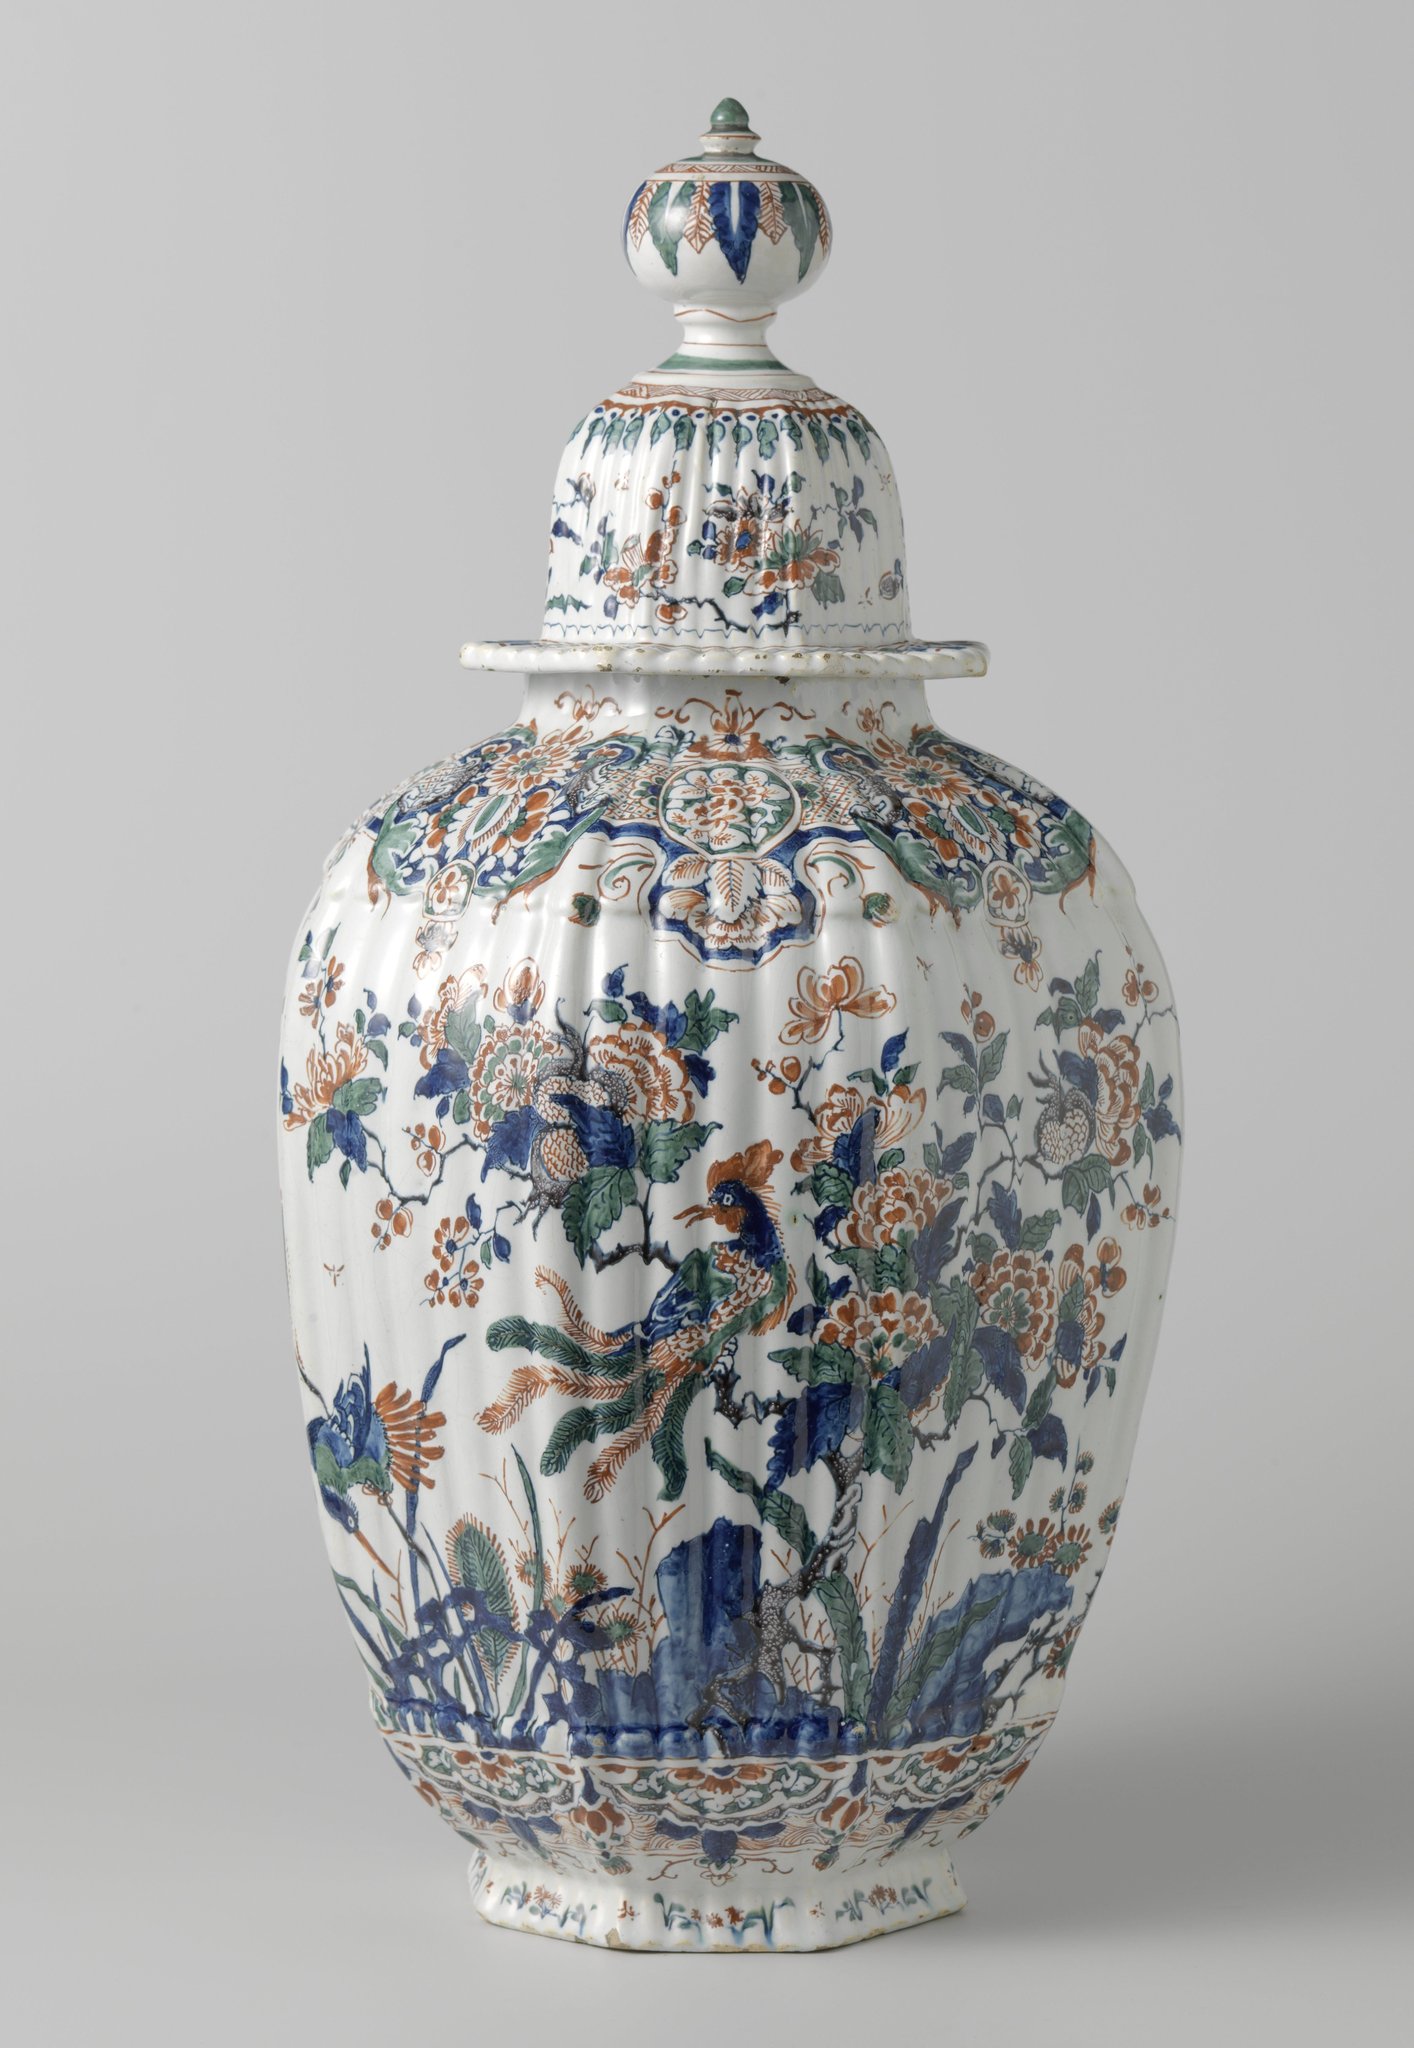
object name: vase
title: Achtkantige geribde vaas van veelkleurig beschilderde faïence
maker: lambertus van eenhoorn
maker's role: plateelbakker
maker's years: 1651-1721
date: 1695-1725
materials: earthenware, glaze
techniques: painted, polychromy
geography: delft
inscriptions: mark: ‘LVE (ineen)/ IVK (ineen) / 3/ 0’, collector's mark: ‘collection J.F. Loudon’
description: Achtkantige, geribde vaas van veelkleurig beschilderde faïence. De vaas is beschilderd met bloemen, rotsen, vogels en een vogel in een boom. De vaas is onderdeel van een stel, de andere delen zijn: drie identieke potten en een identieke vaas. De delen zijn gemerkt.